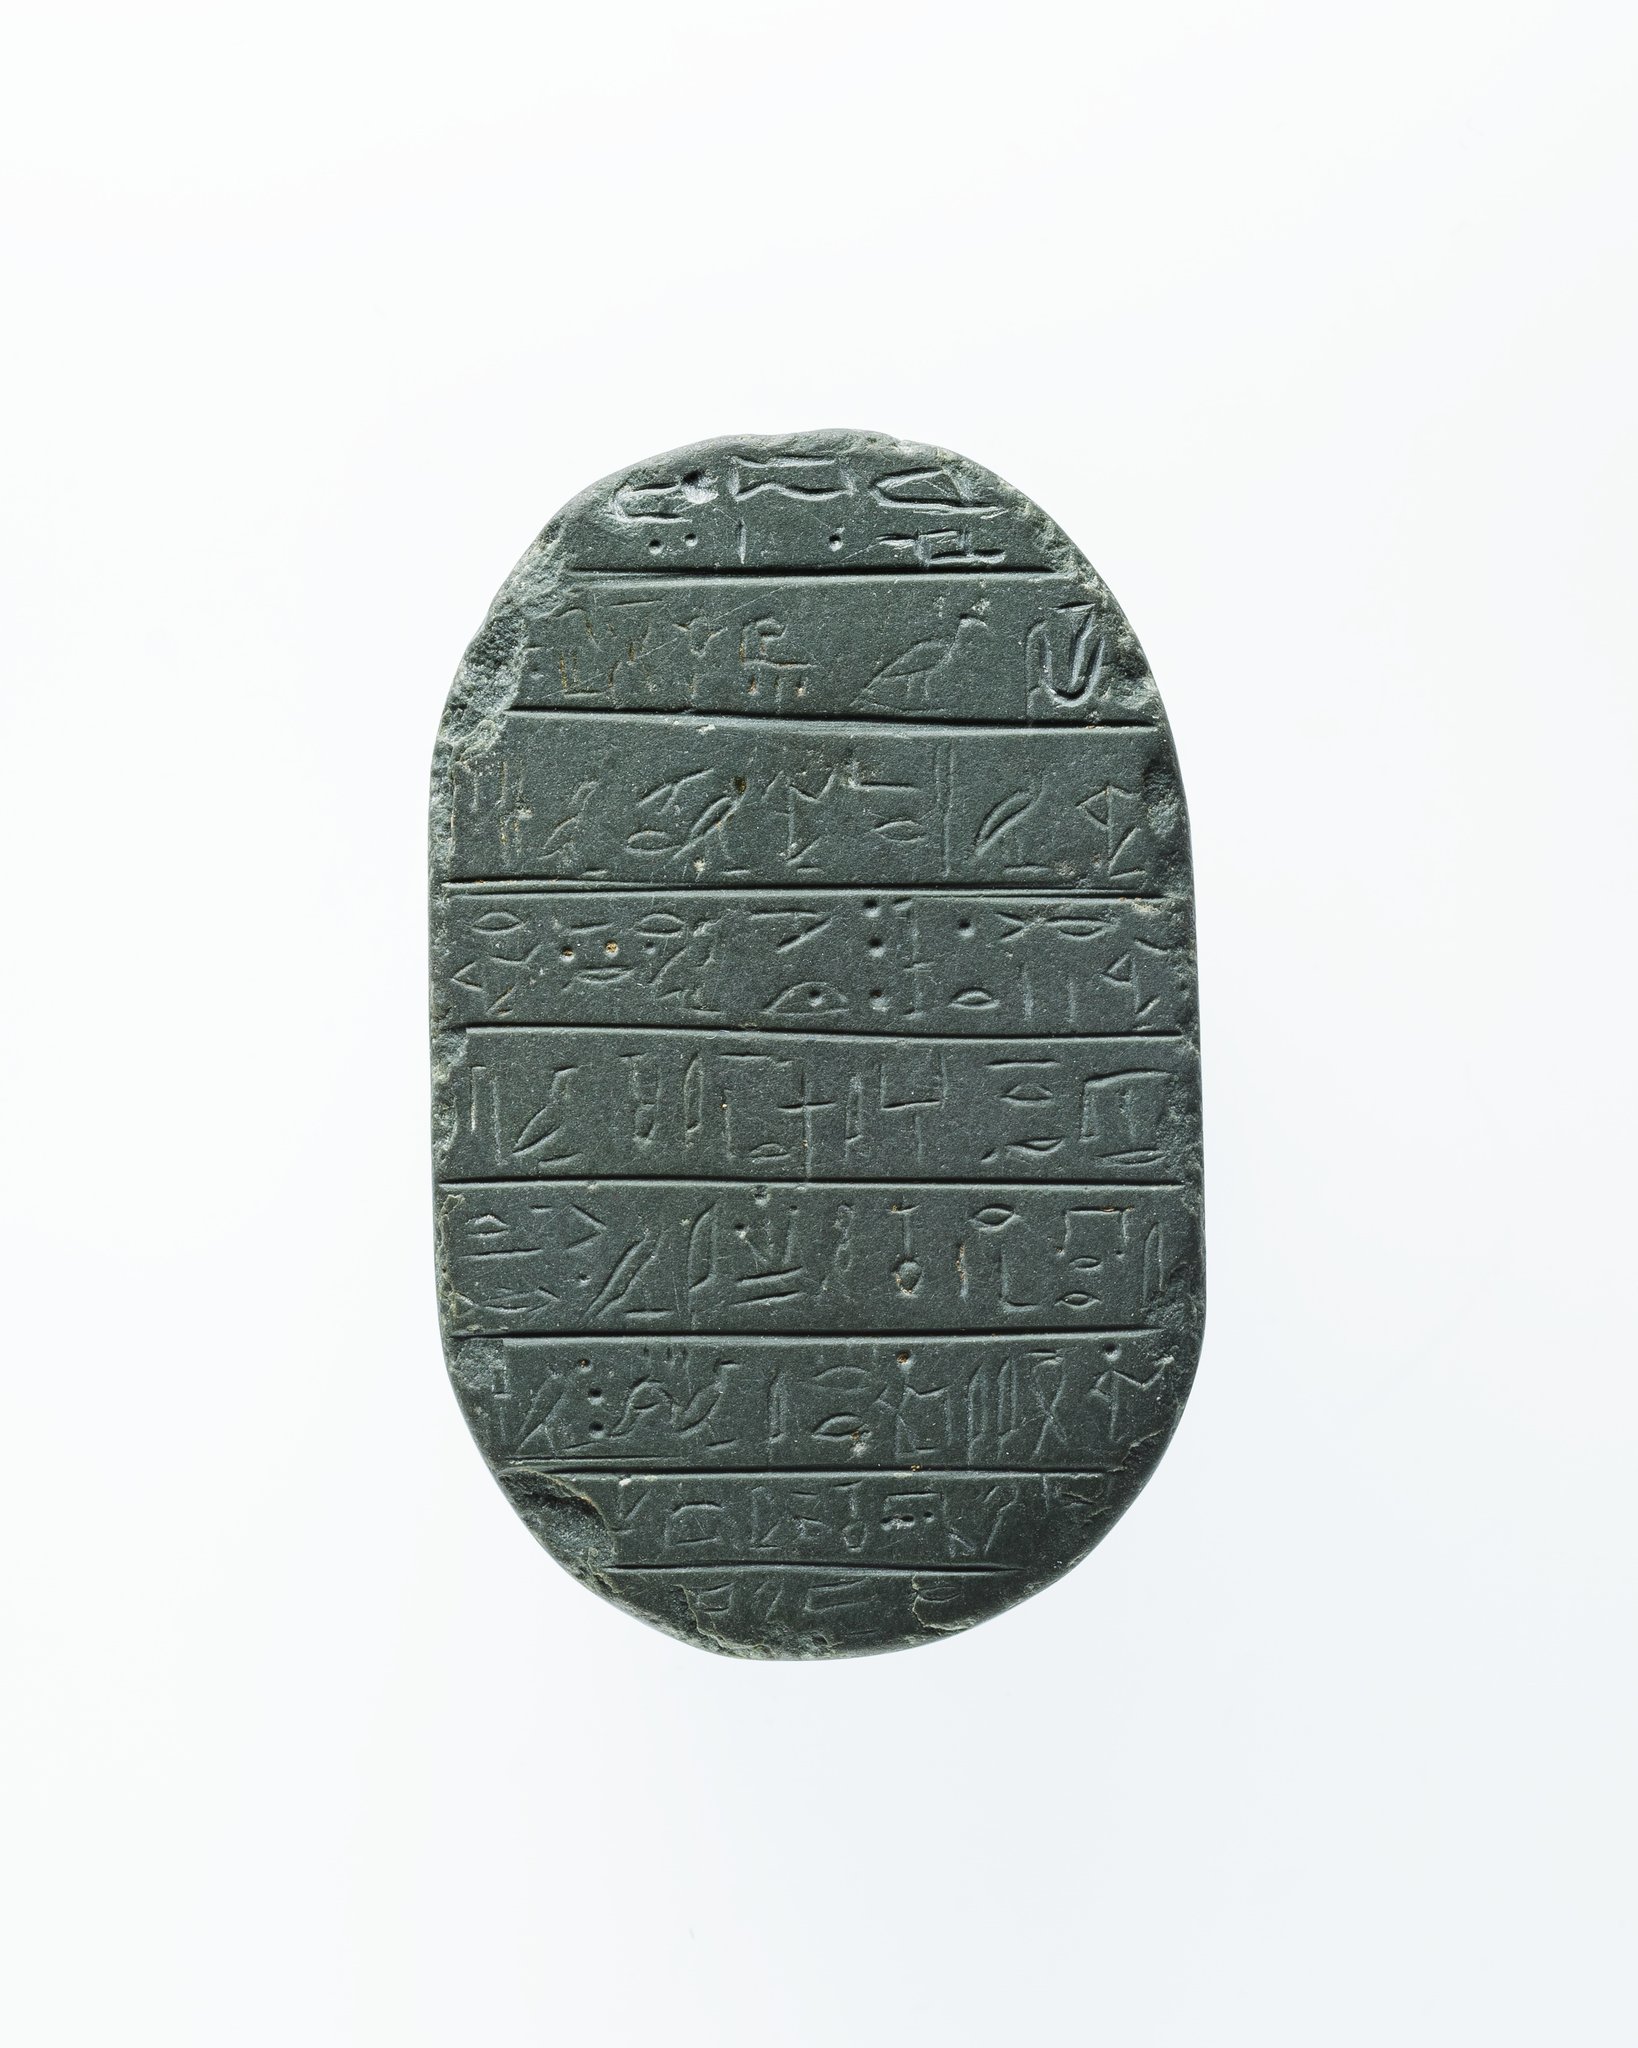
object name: heart scarab, gautsoshen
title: Heart Scarab inscribed for Gautsoshen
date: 1070-945 BCE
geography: egypt